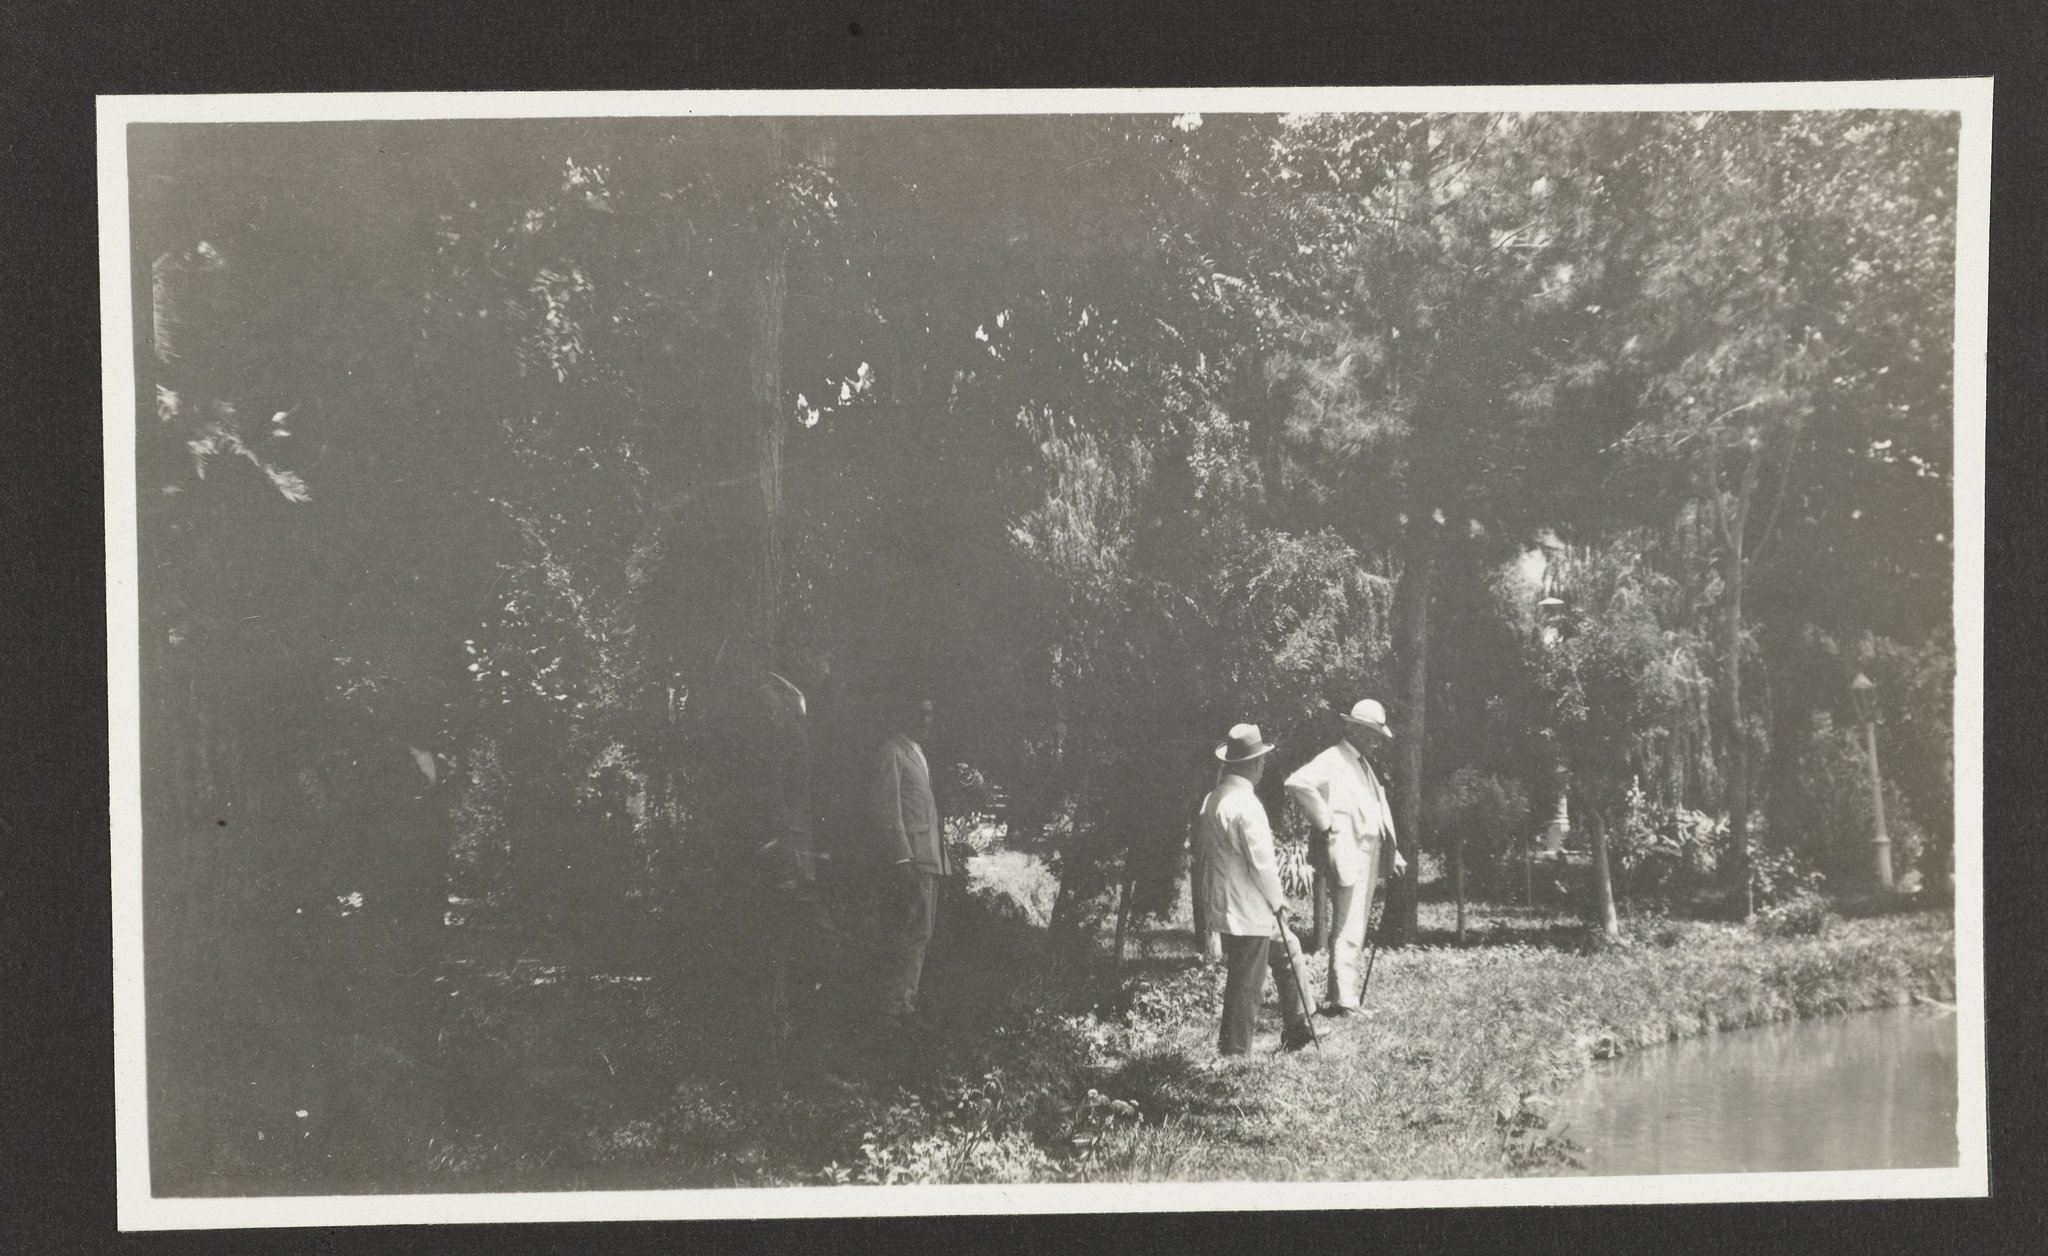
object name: photograph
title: Paleistuin te Ferabad (omtrek Teheran).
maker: a.g.a. van eelde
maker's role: engineer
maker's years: 1862-1950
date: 1925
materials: cardboard, paper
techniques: gelatin silver print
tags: iran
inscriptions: number: ‘32.’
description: Titel op object afkomstig uit inventaris (Verklaring der Photo's) behorend bij het album.